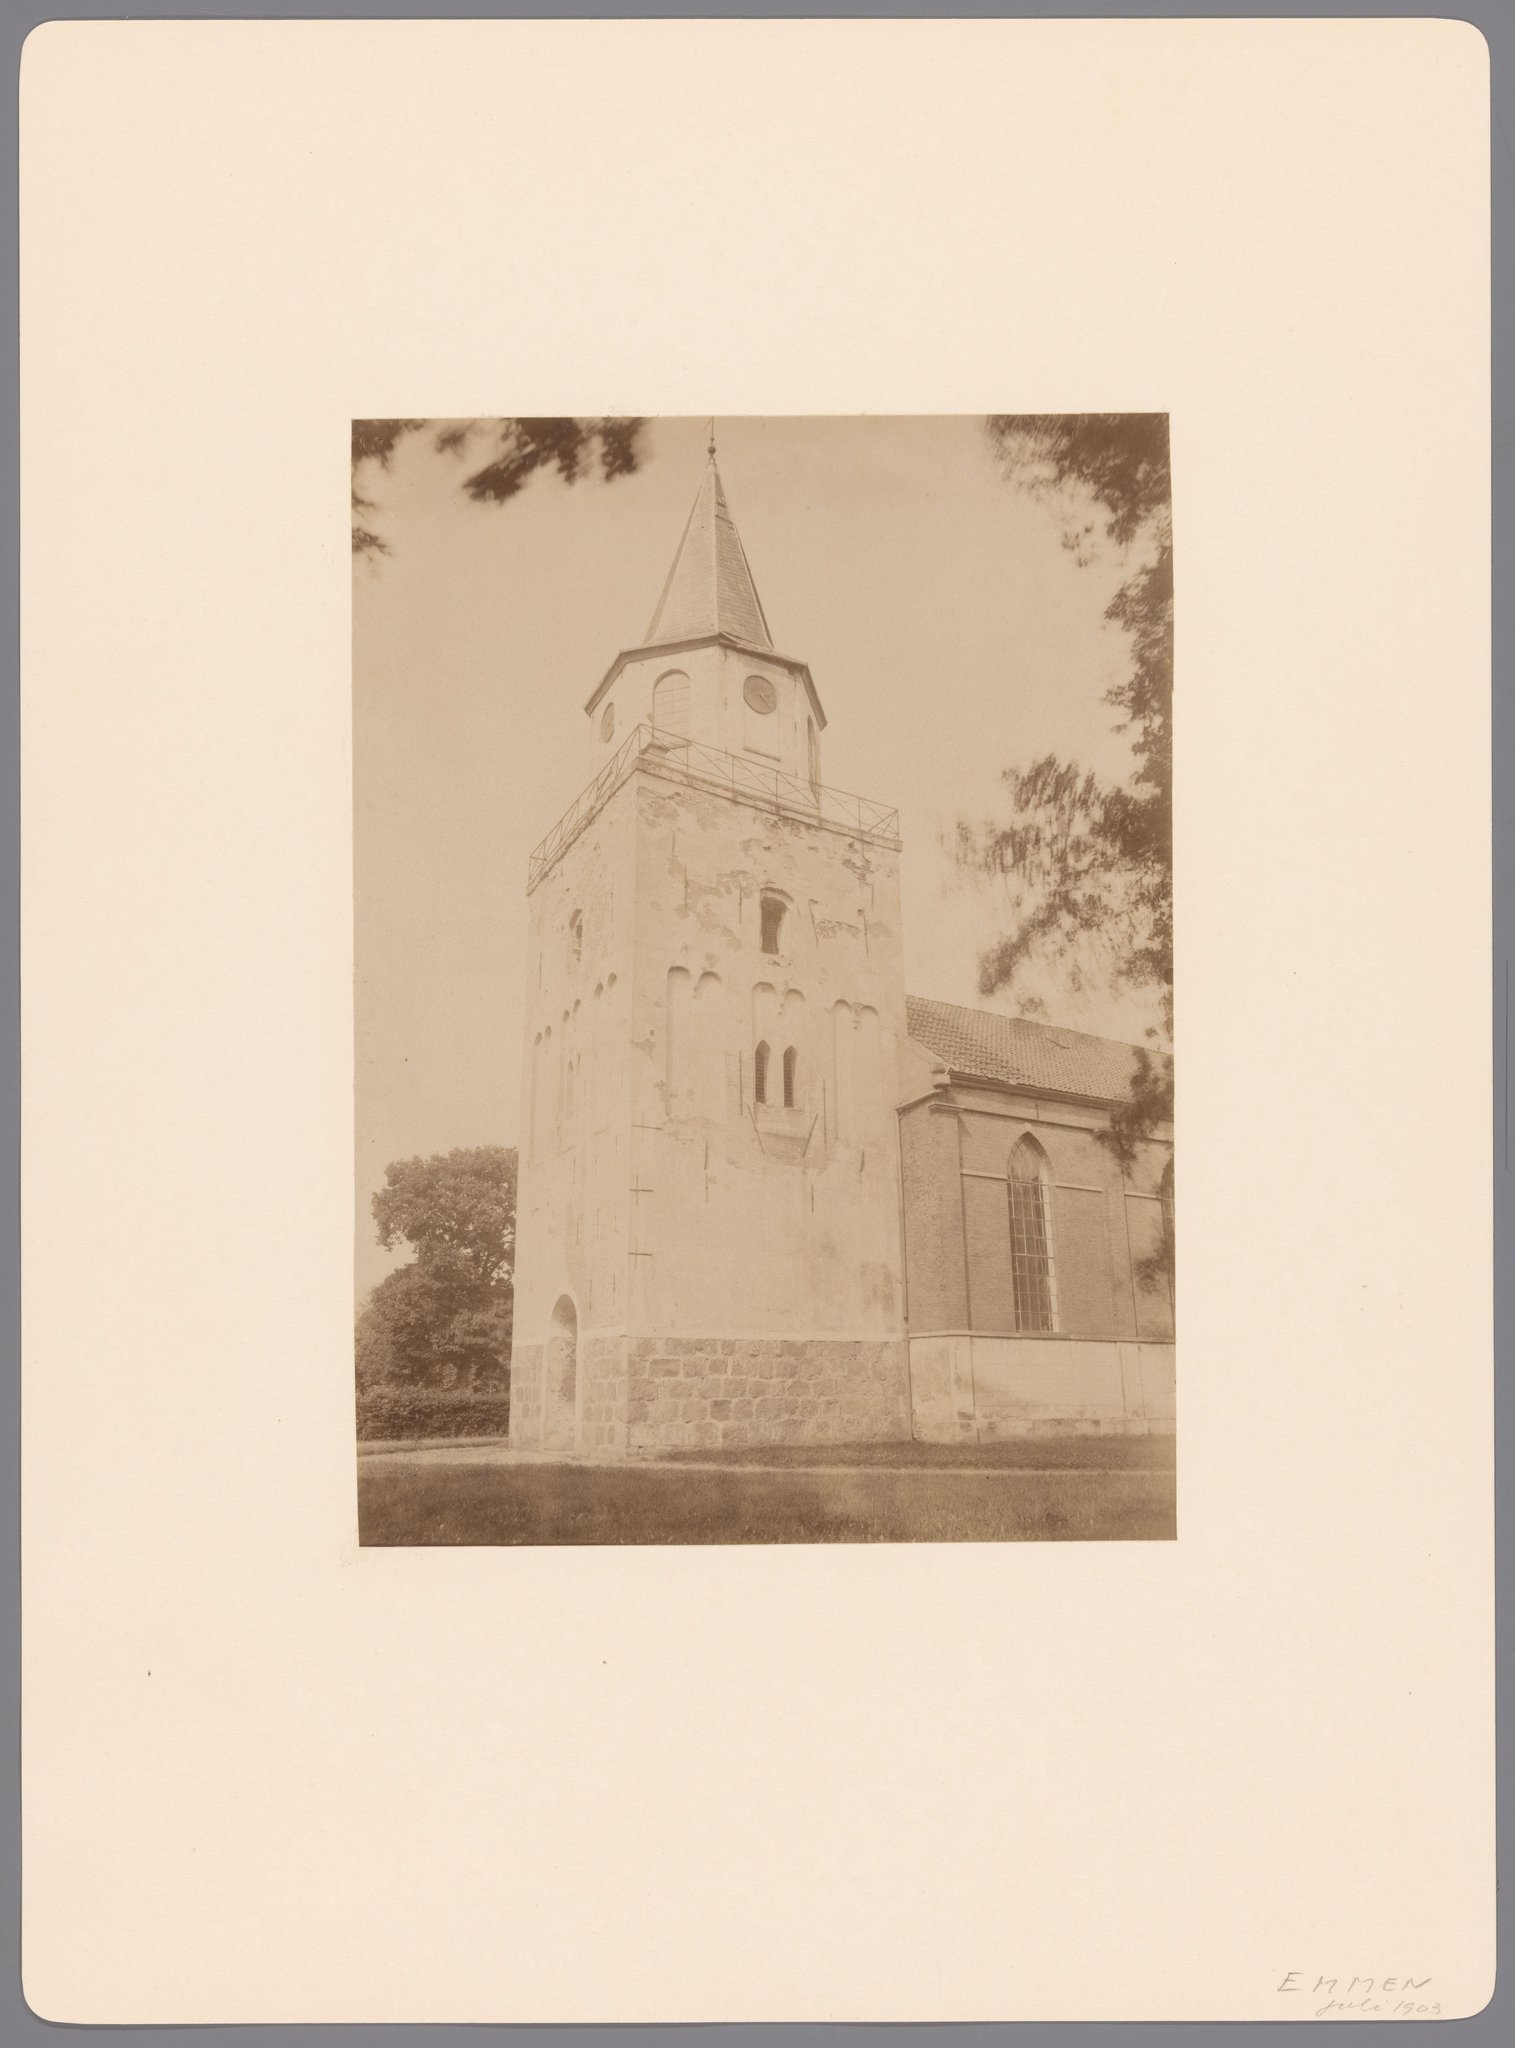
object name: photograph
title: Toren van de Grote of Sint-Pancratiuskerk te Emmen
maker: anoniem (monumentenzorg)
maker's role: fotograaf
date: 1903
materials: cardboard, photographic support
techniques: albumen print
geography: emmen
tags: parts of church exterior and annexes: tower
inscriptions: annotation: ‘Emmen/ juli 1903’, annotation: ‘11’